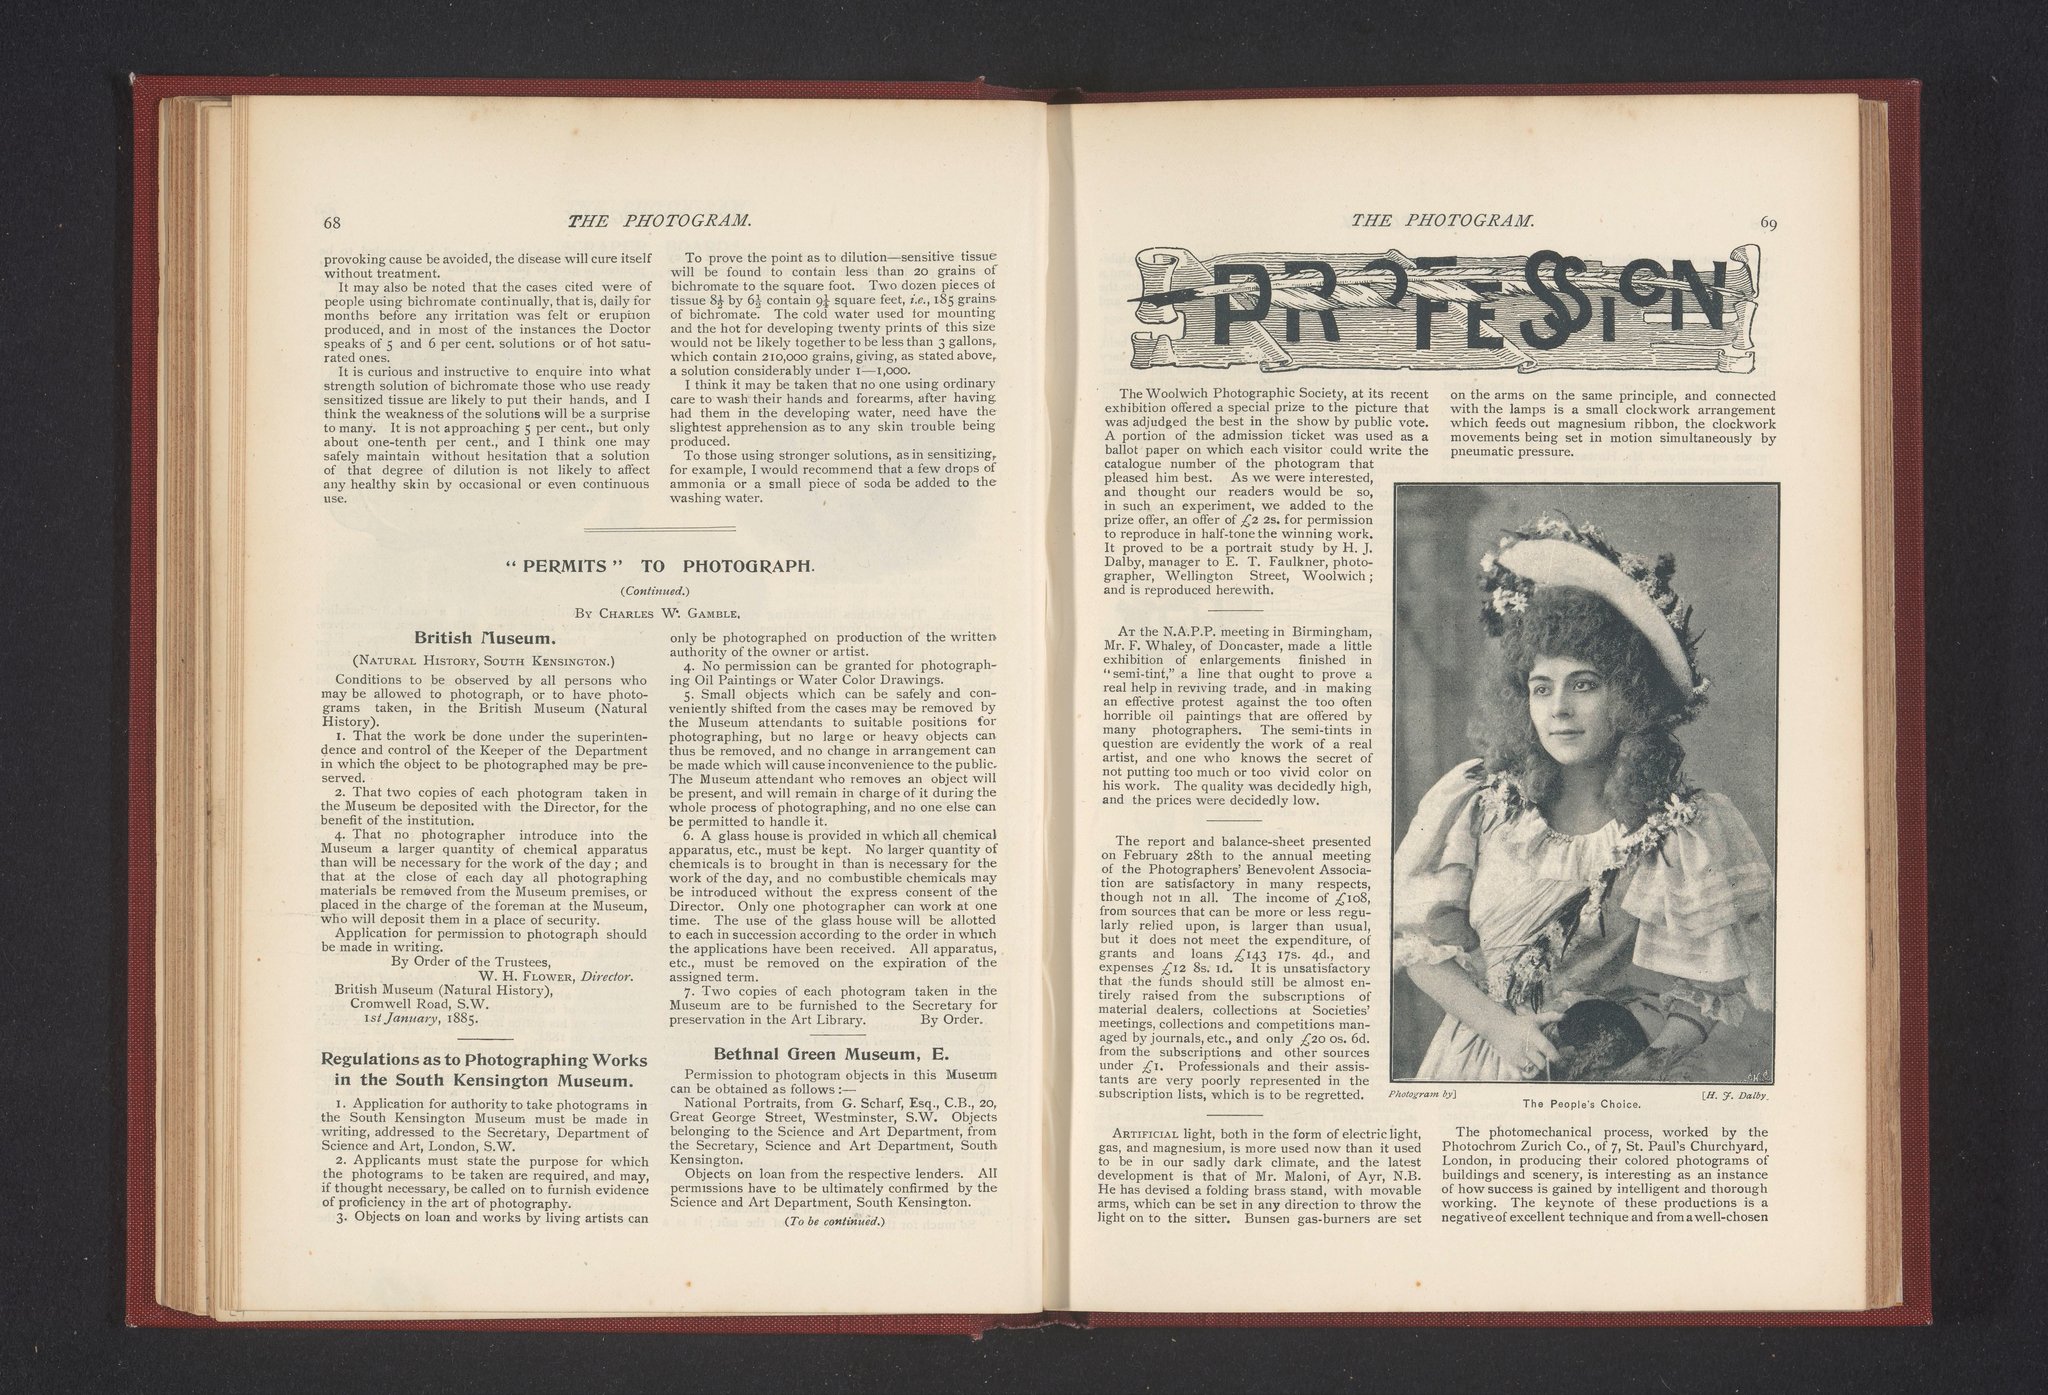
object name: page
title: The people's choice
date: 1889-1894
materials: paper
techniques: autotype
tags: historical persons - bb - woman